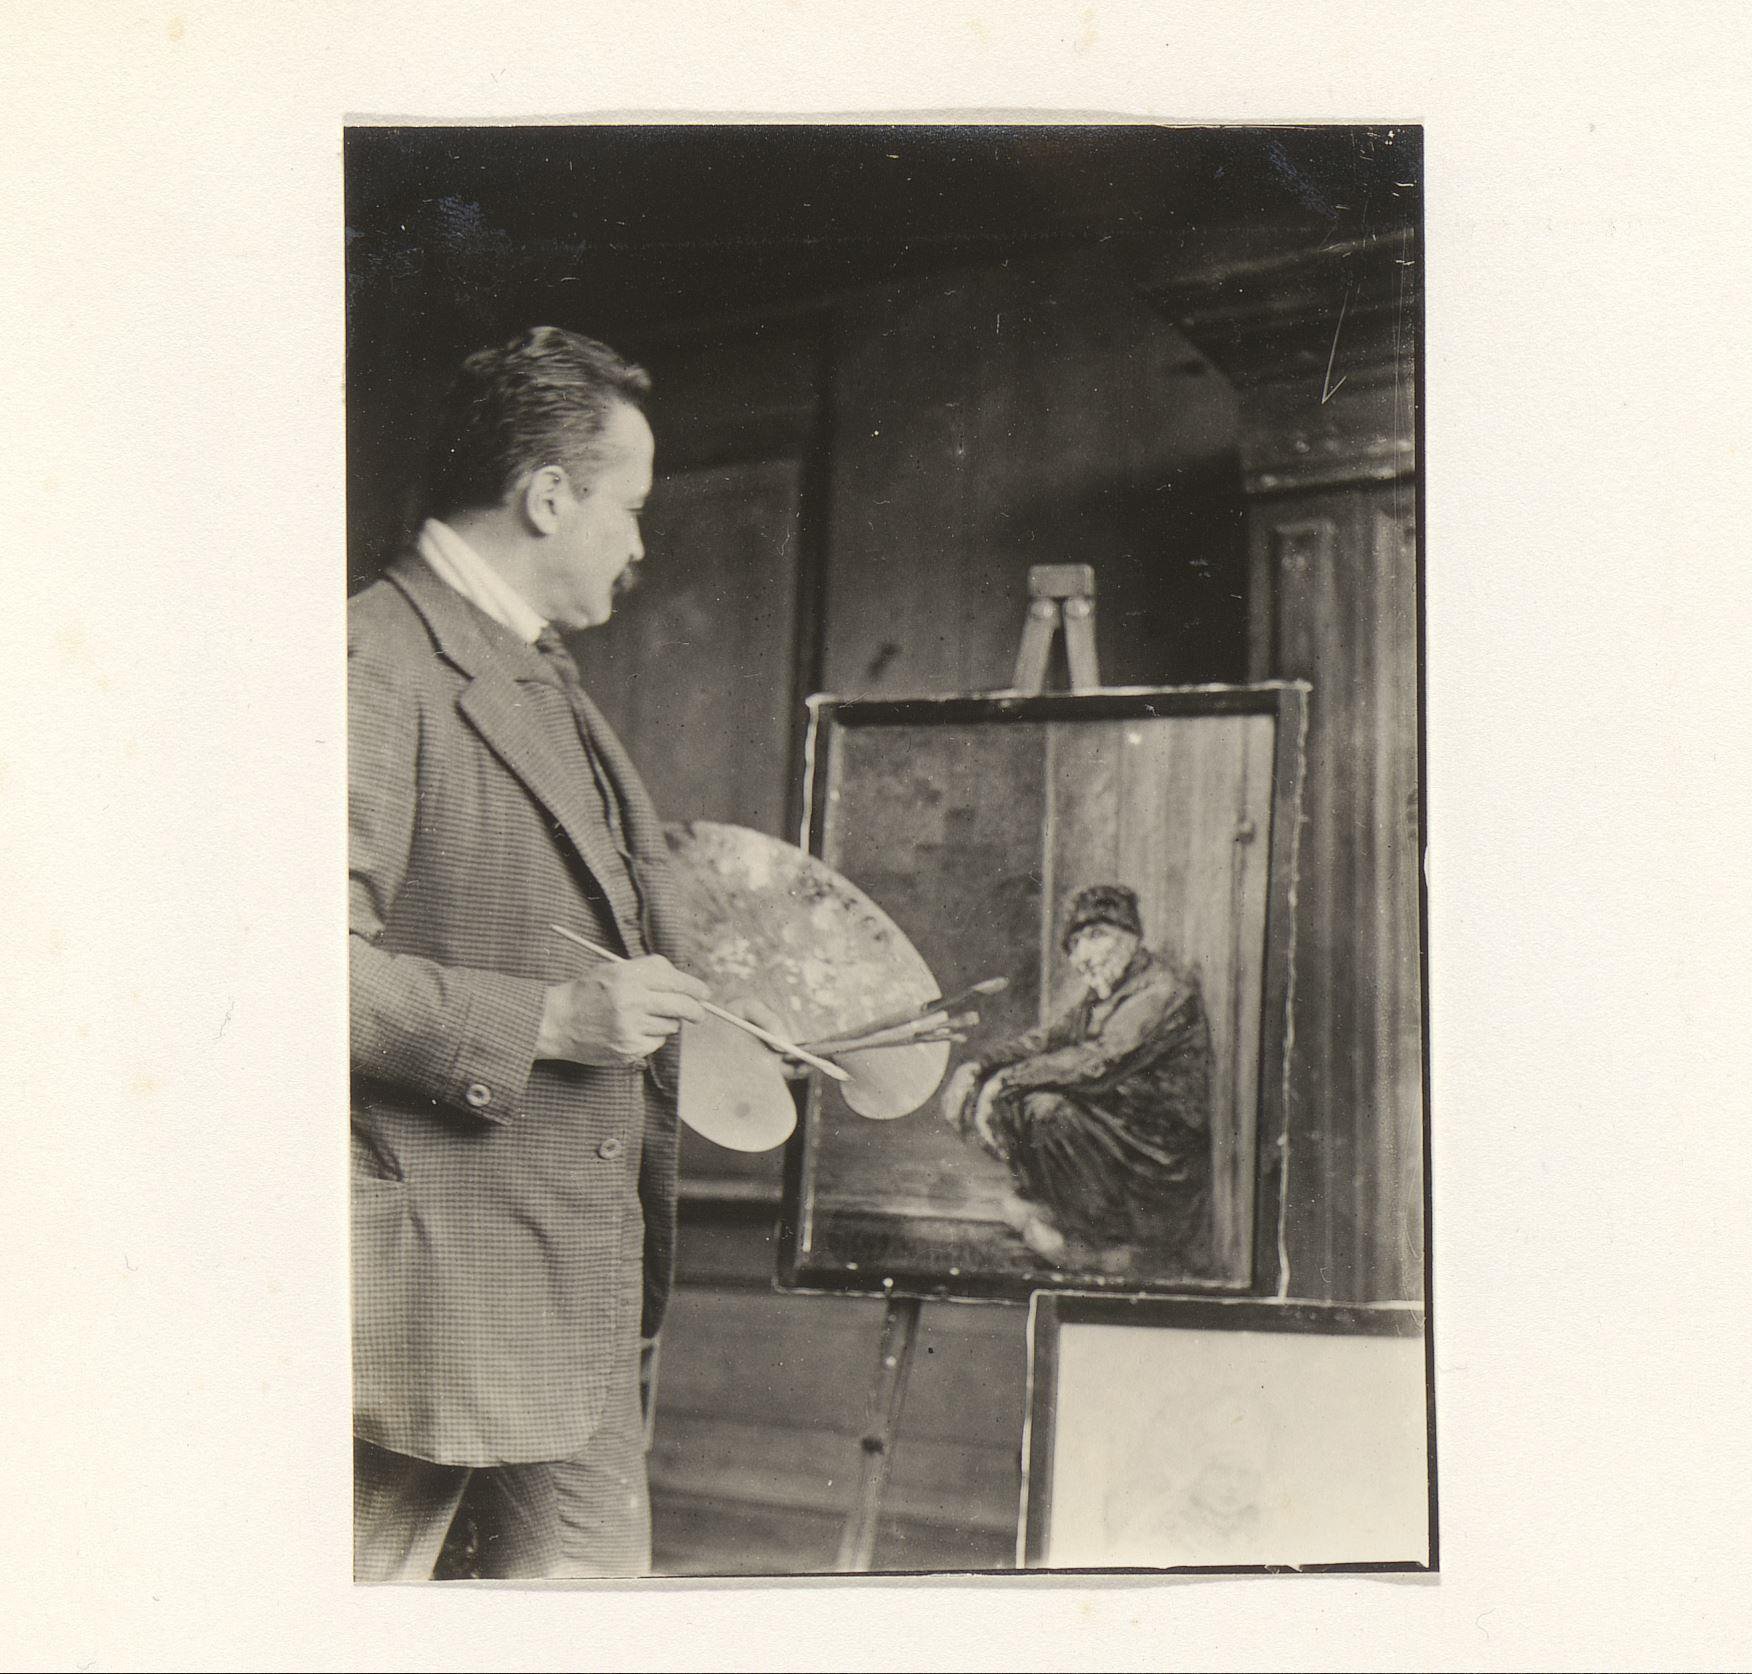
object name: photograph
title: Man in een schildersatelier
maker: george hidderley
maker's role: fotograaf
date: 1900-1910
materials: paper, photographic support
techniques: gelatin silver print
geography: volendam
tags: adult man, historical persons, workshop, studio ~ painter